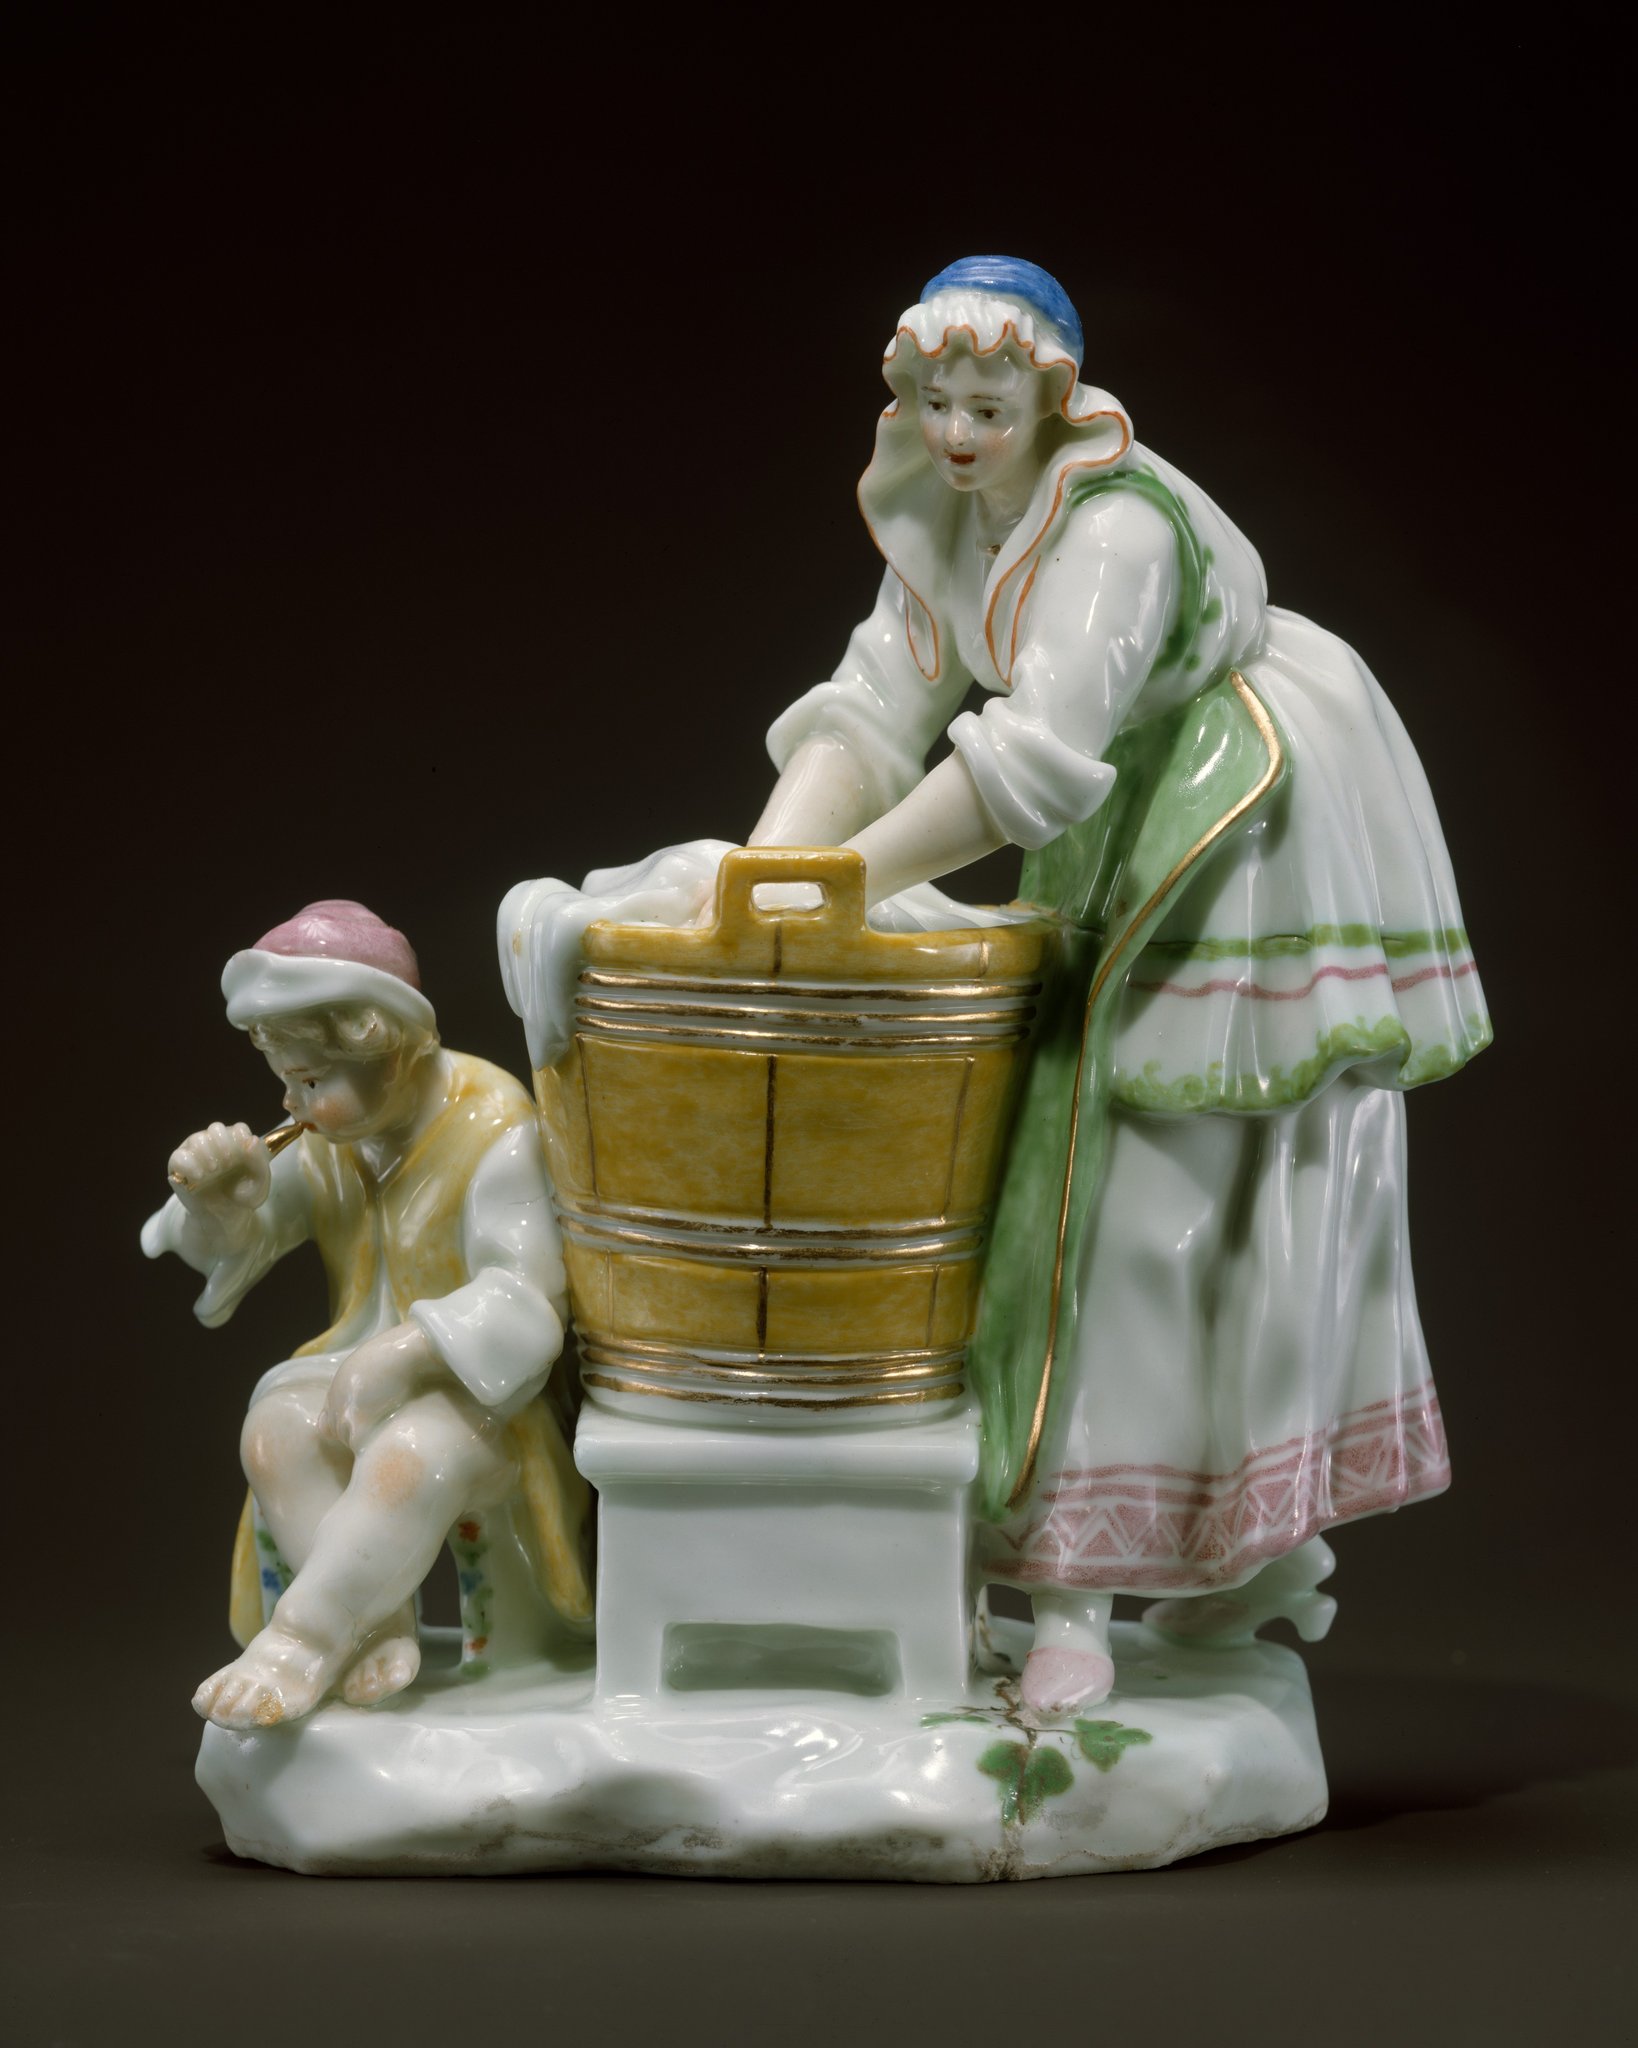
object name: group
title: The Washerwoman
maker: capodimonte porcelain manufactory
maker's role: manufactory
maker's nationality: italian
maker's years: 1740-1759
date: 1752-1758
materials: soft paste porcelain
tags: boys,women,working